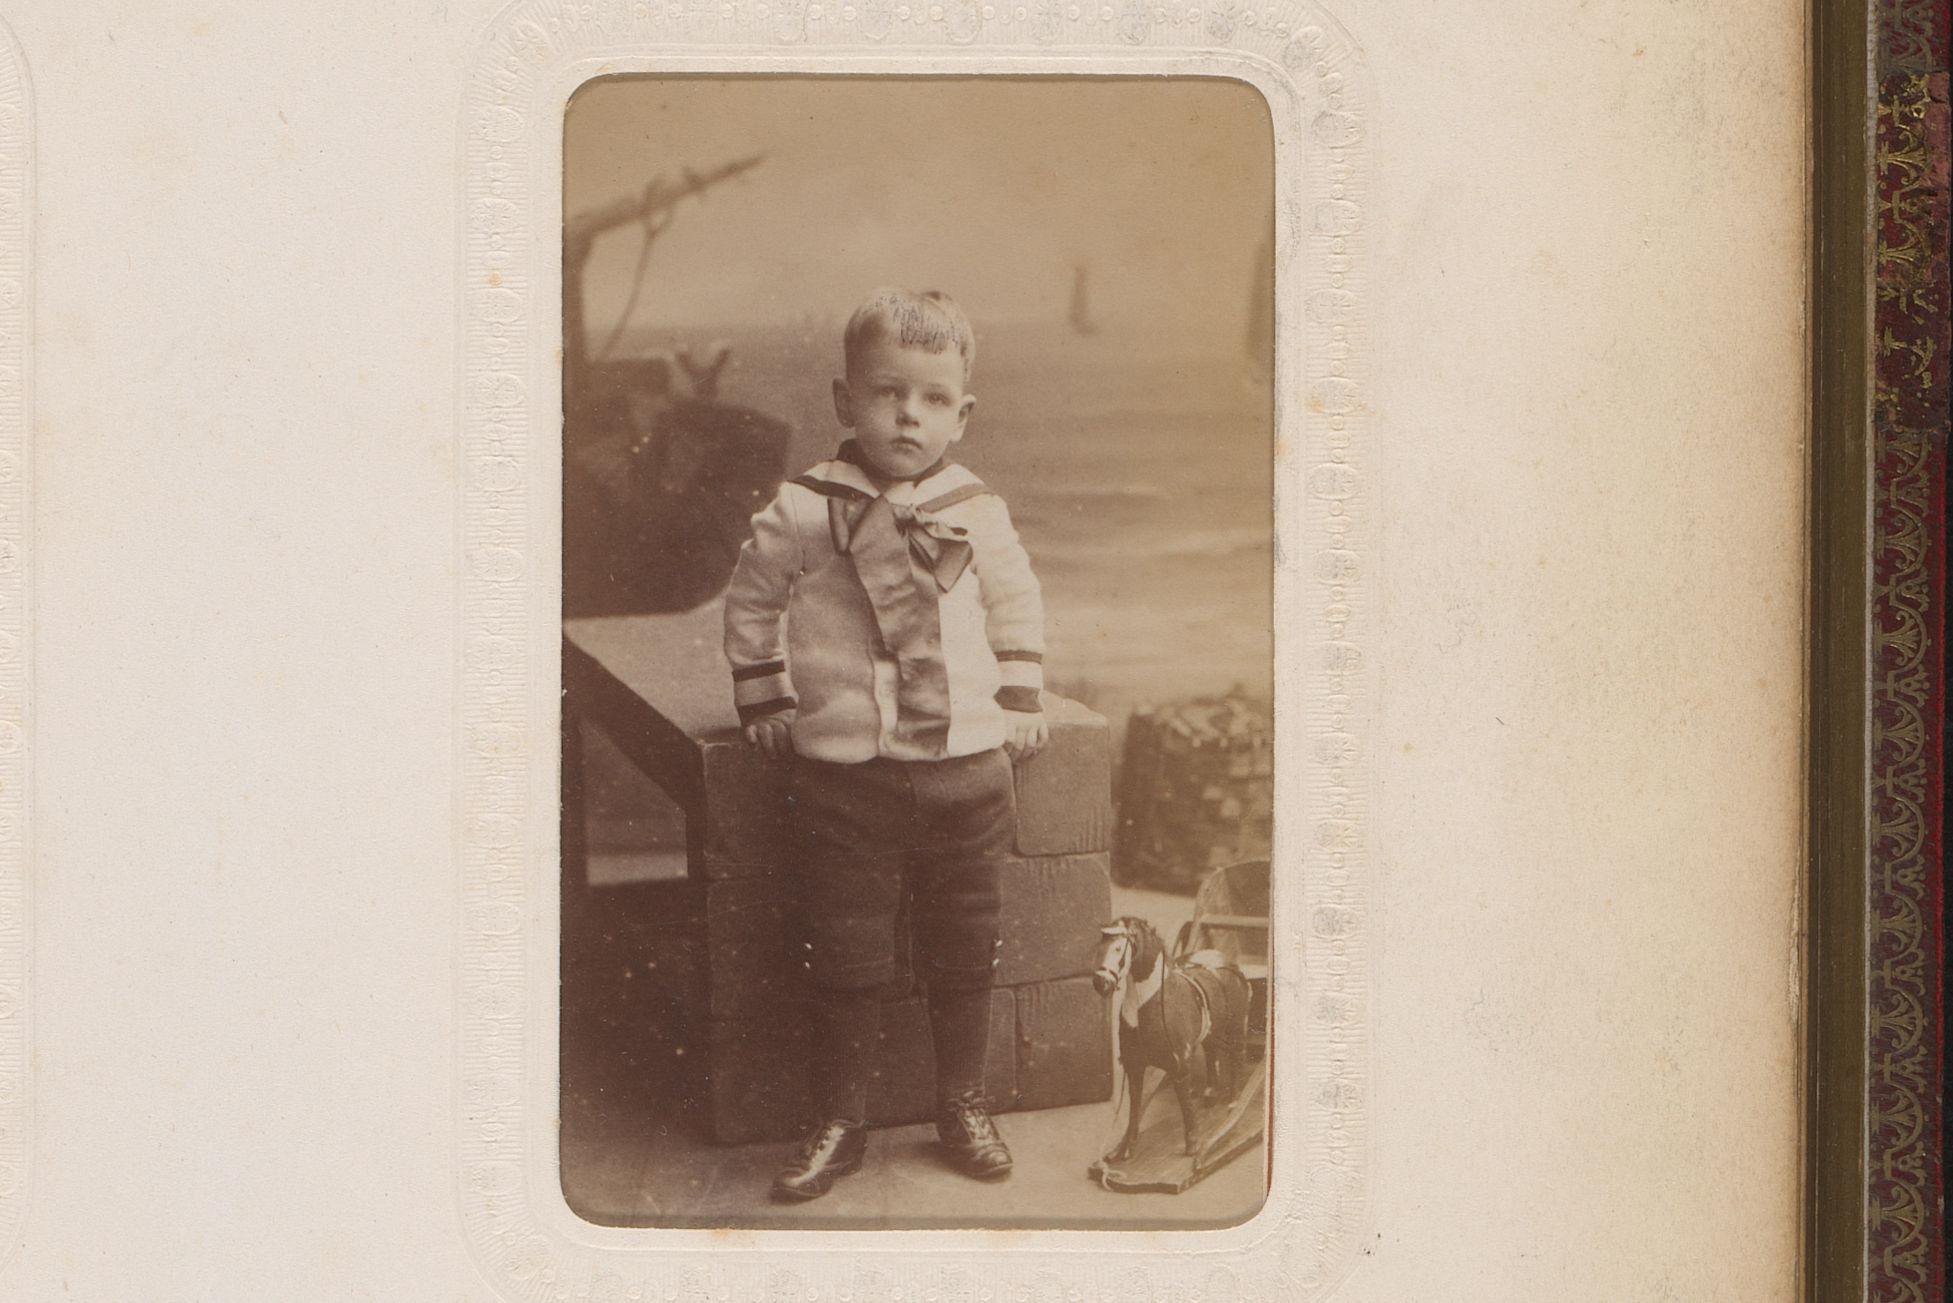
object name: photograph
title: Portret van een jongen op een driewieler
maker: Anonymous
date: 1860-1900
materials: cardboard, photographic support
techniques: albumen print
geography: netherlands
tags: boy (child between toddler and youth), tricycle, historical persons